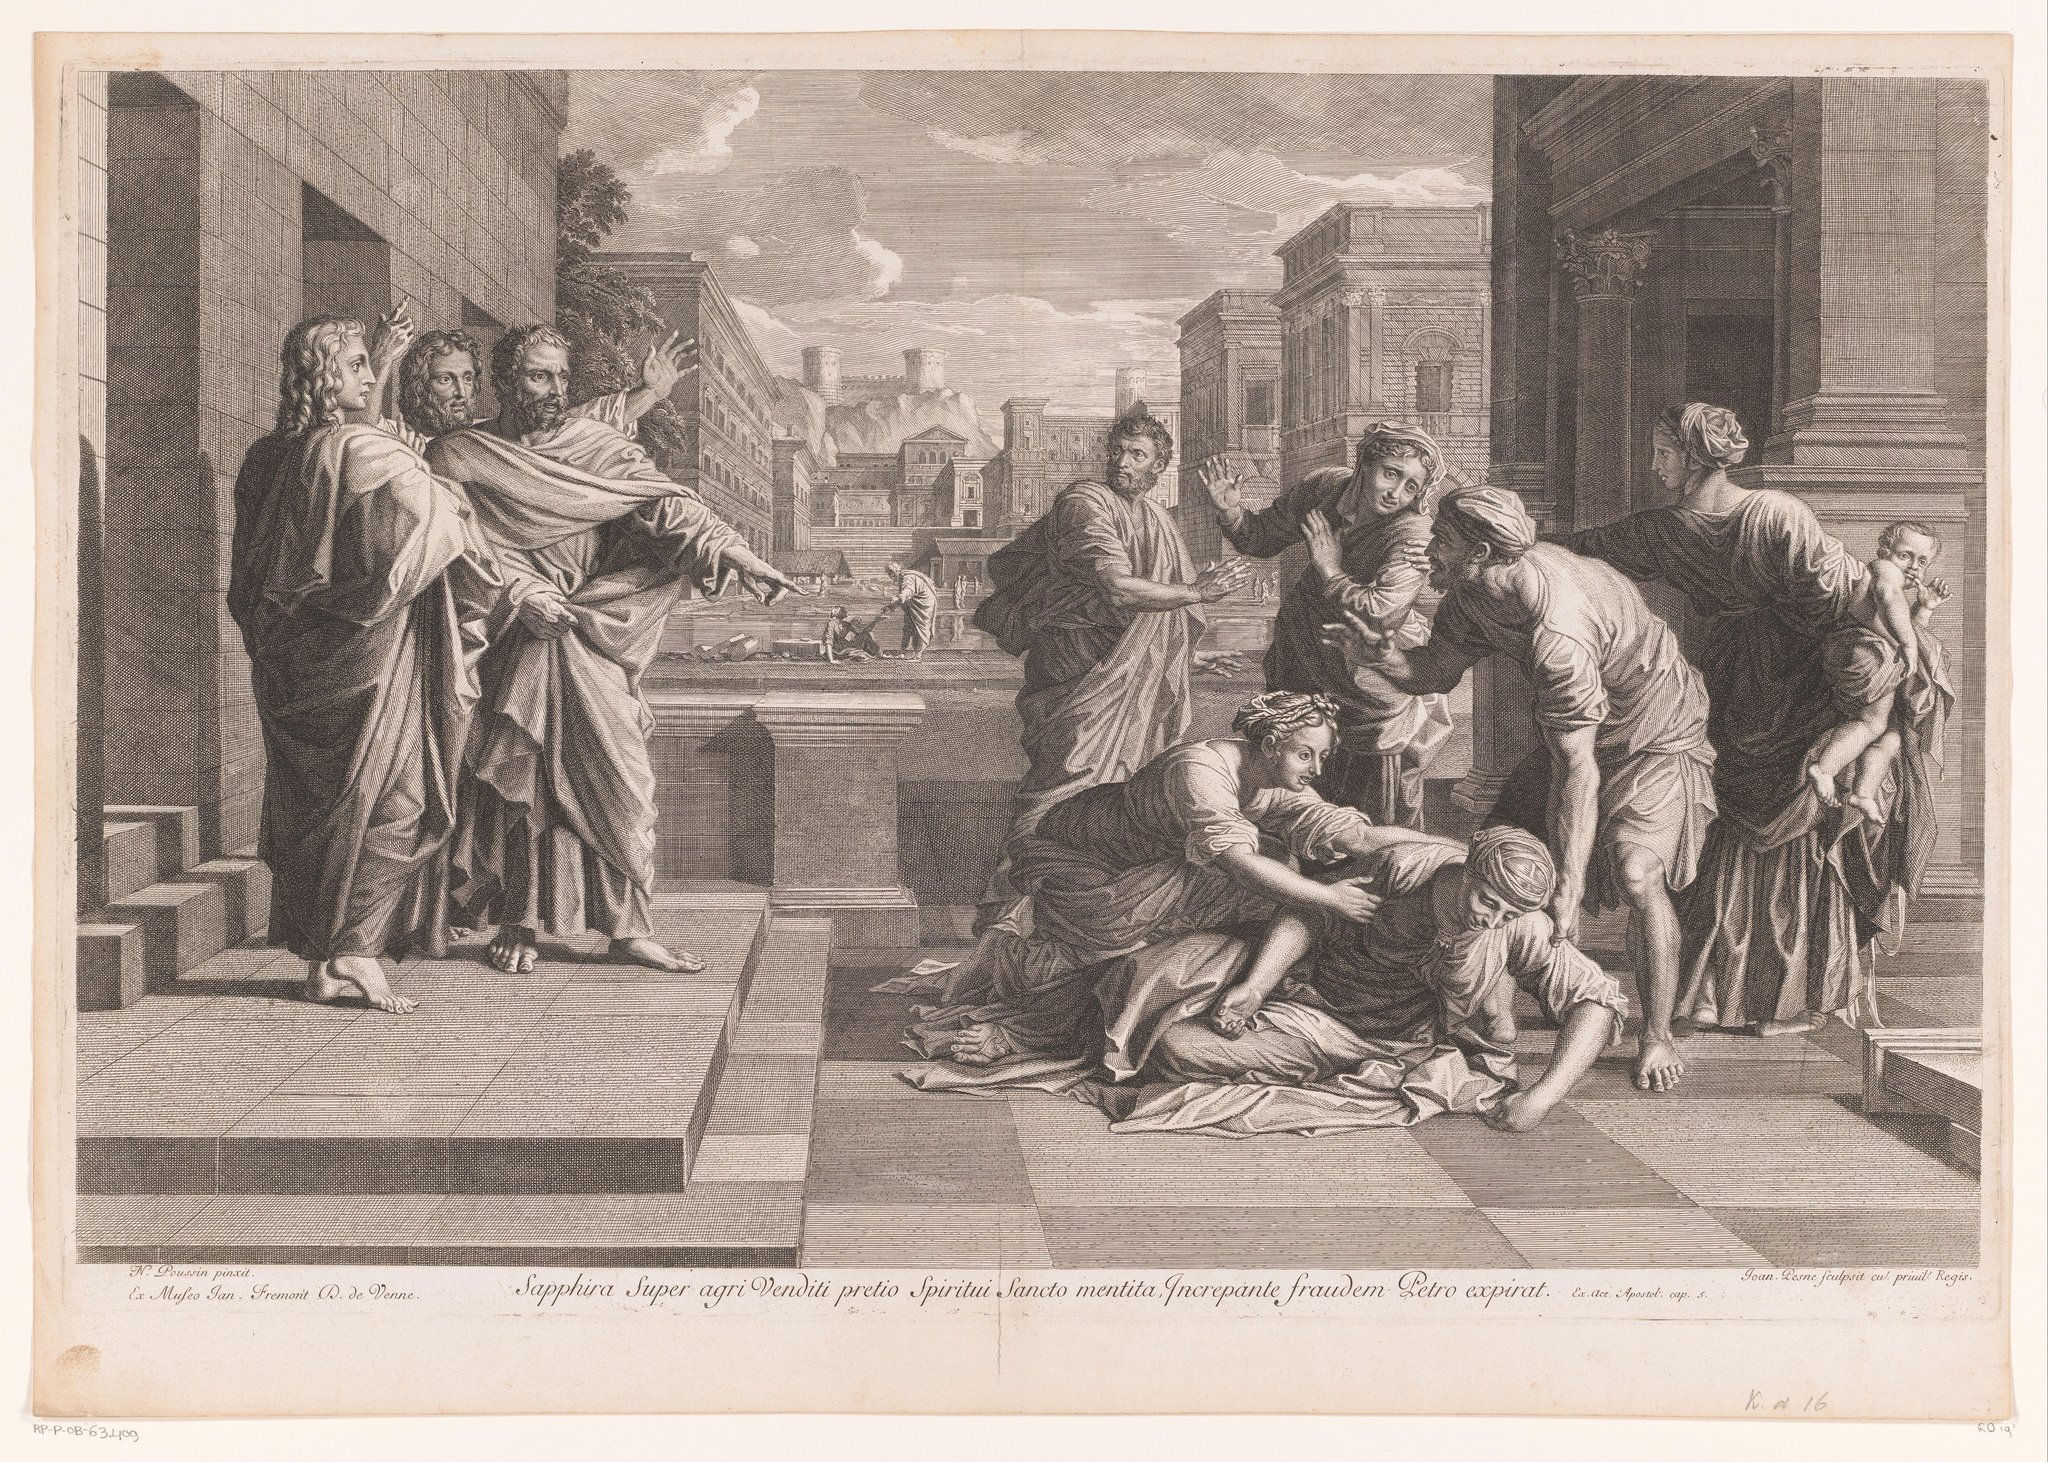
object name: print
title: Dood van Saffira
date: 1633-1700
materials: paper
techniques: engraving, etching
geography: france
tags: peter questioning sapphira, who then dies too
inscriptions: collector's mark: Lugt 240